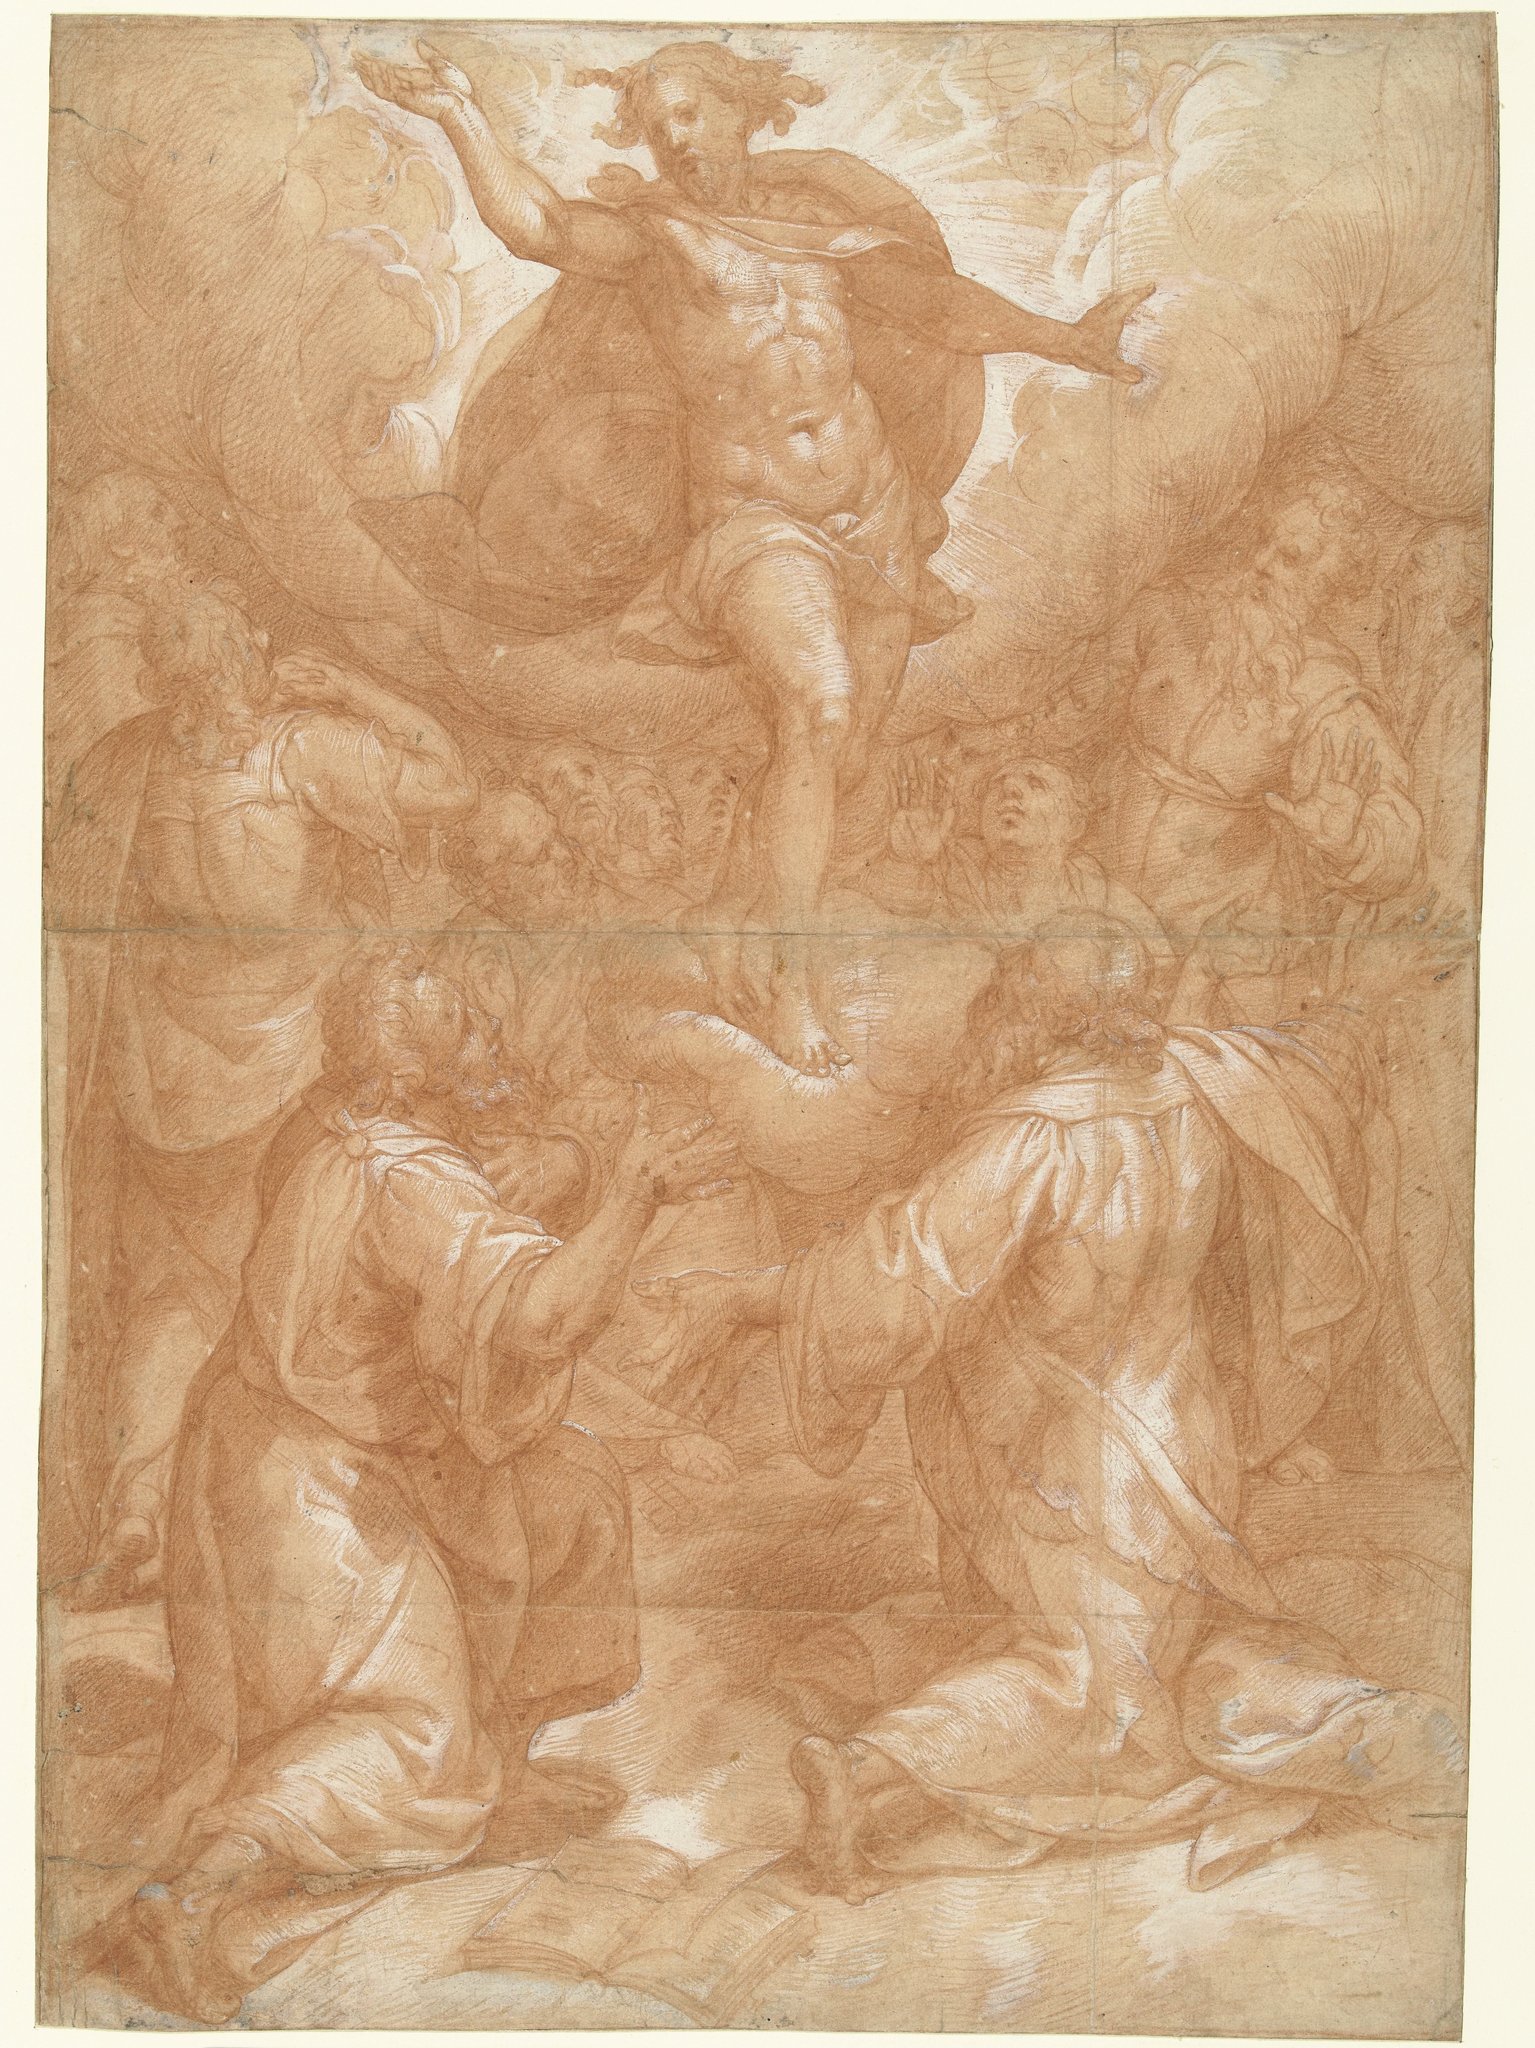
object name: drawing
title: Hemelvaart van Christus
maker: denys calvaert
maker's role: draughtsman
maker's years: 1540-1619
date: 1570-1580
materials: chalk, paint, paper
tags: the ascension (christ surrounded by radiant light or in a mandorla)